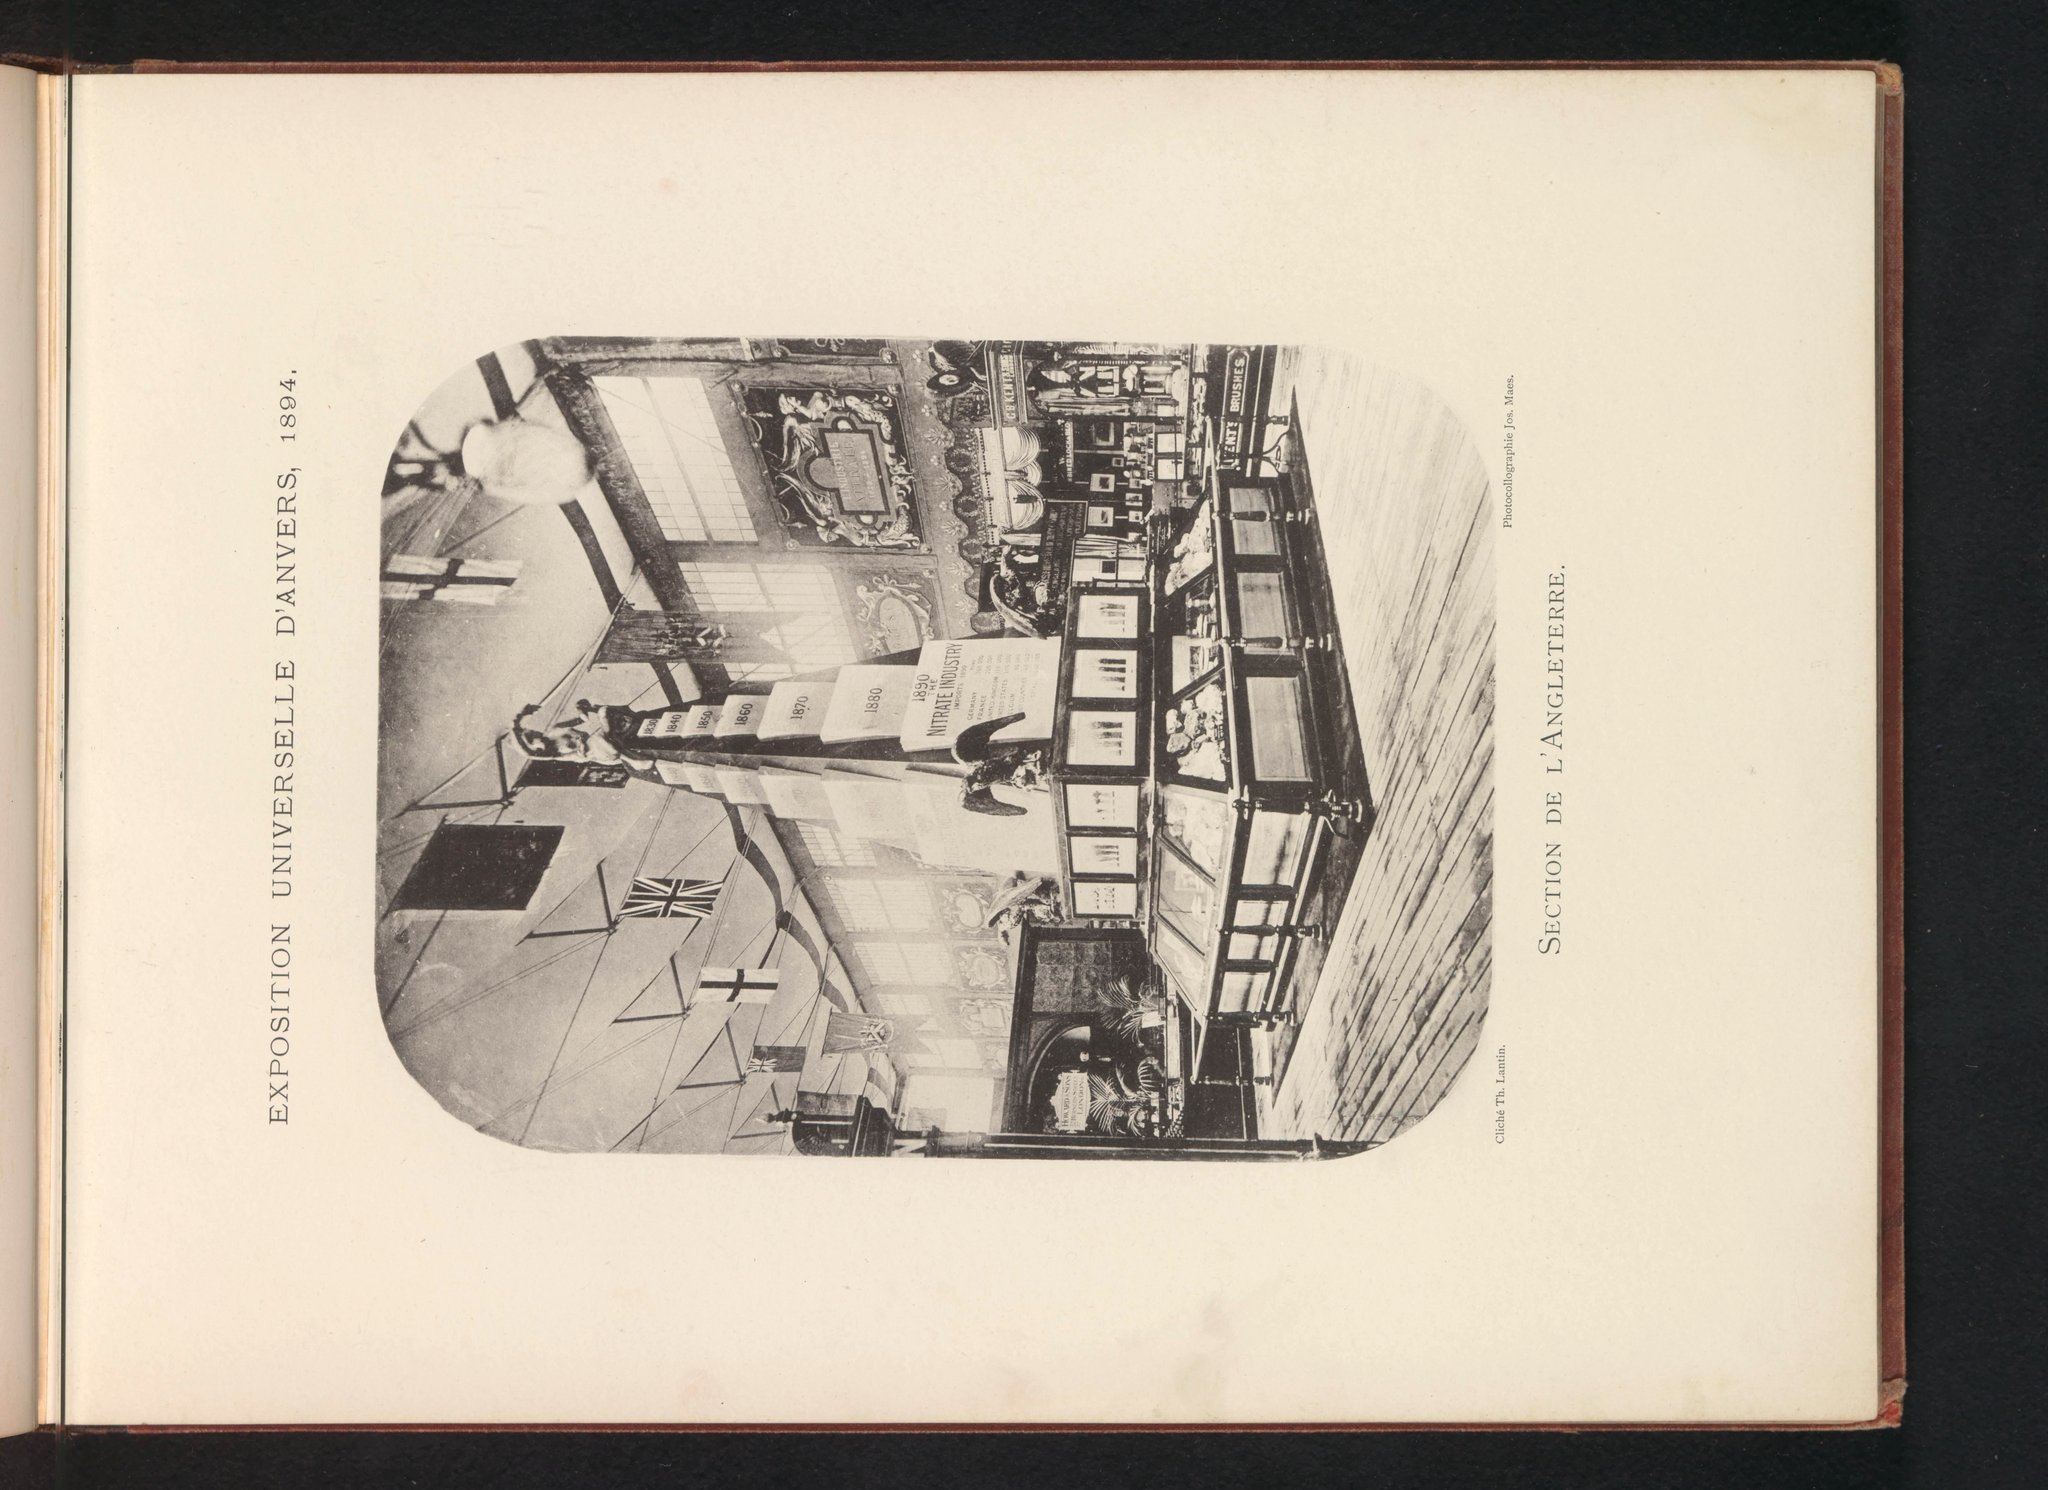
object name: page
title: Expositie van Britse objecten tijdens de wereldtentoonstelling te Antwerpen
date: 1894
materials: paper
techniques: photograph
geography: antwerp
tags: world fair, world exhibition, collection, exhibition, show